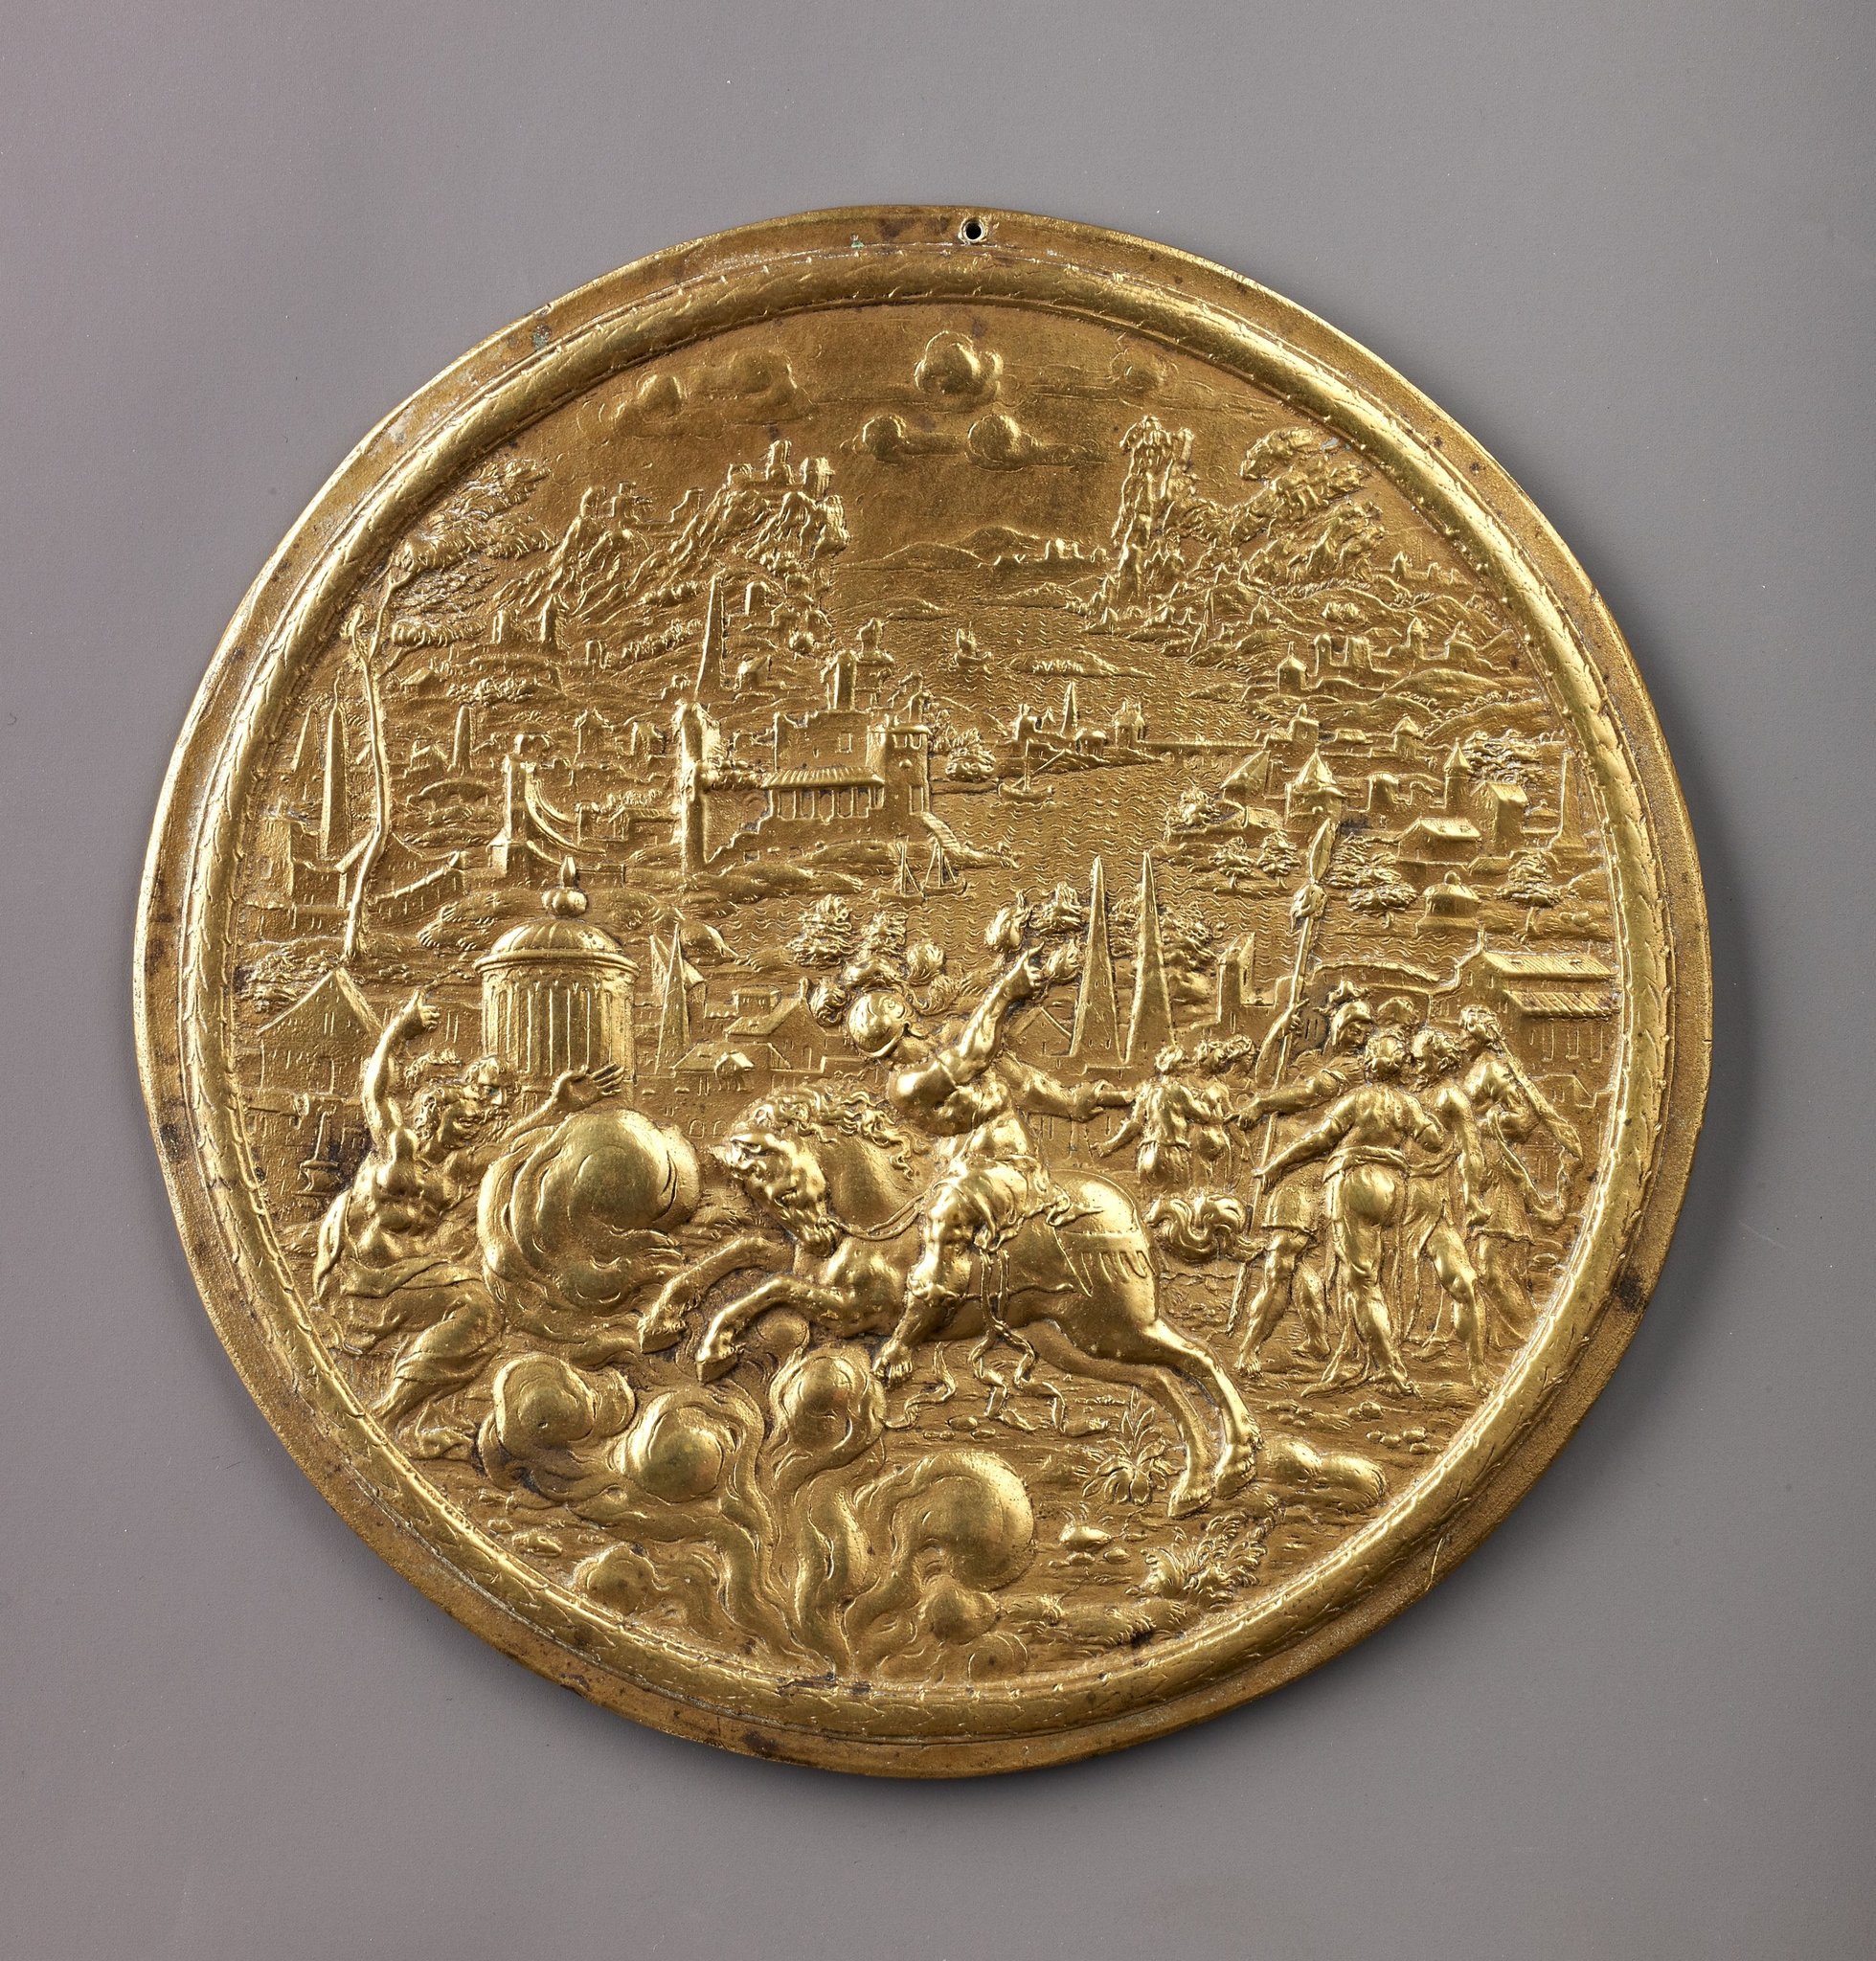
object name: plaquette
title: Self-sacrifice of Marcus Curtius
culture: german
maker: paulus willemsz. van vianen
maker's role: artist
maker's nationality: netherlandish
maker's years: 1565-1619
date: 1596-1600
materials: copper alloy, gilt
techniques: casting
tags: cities,men,horses